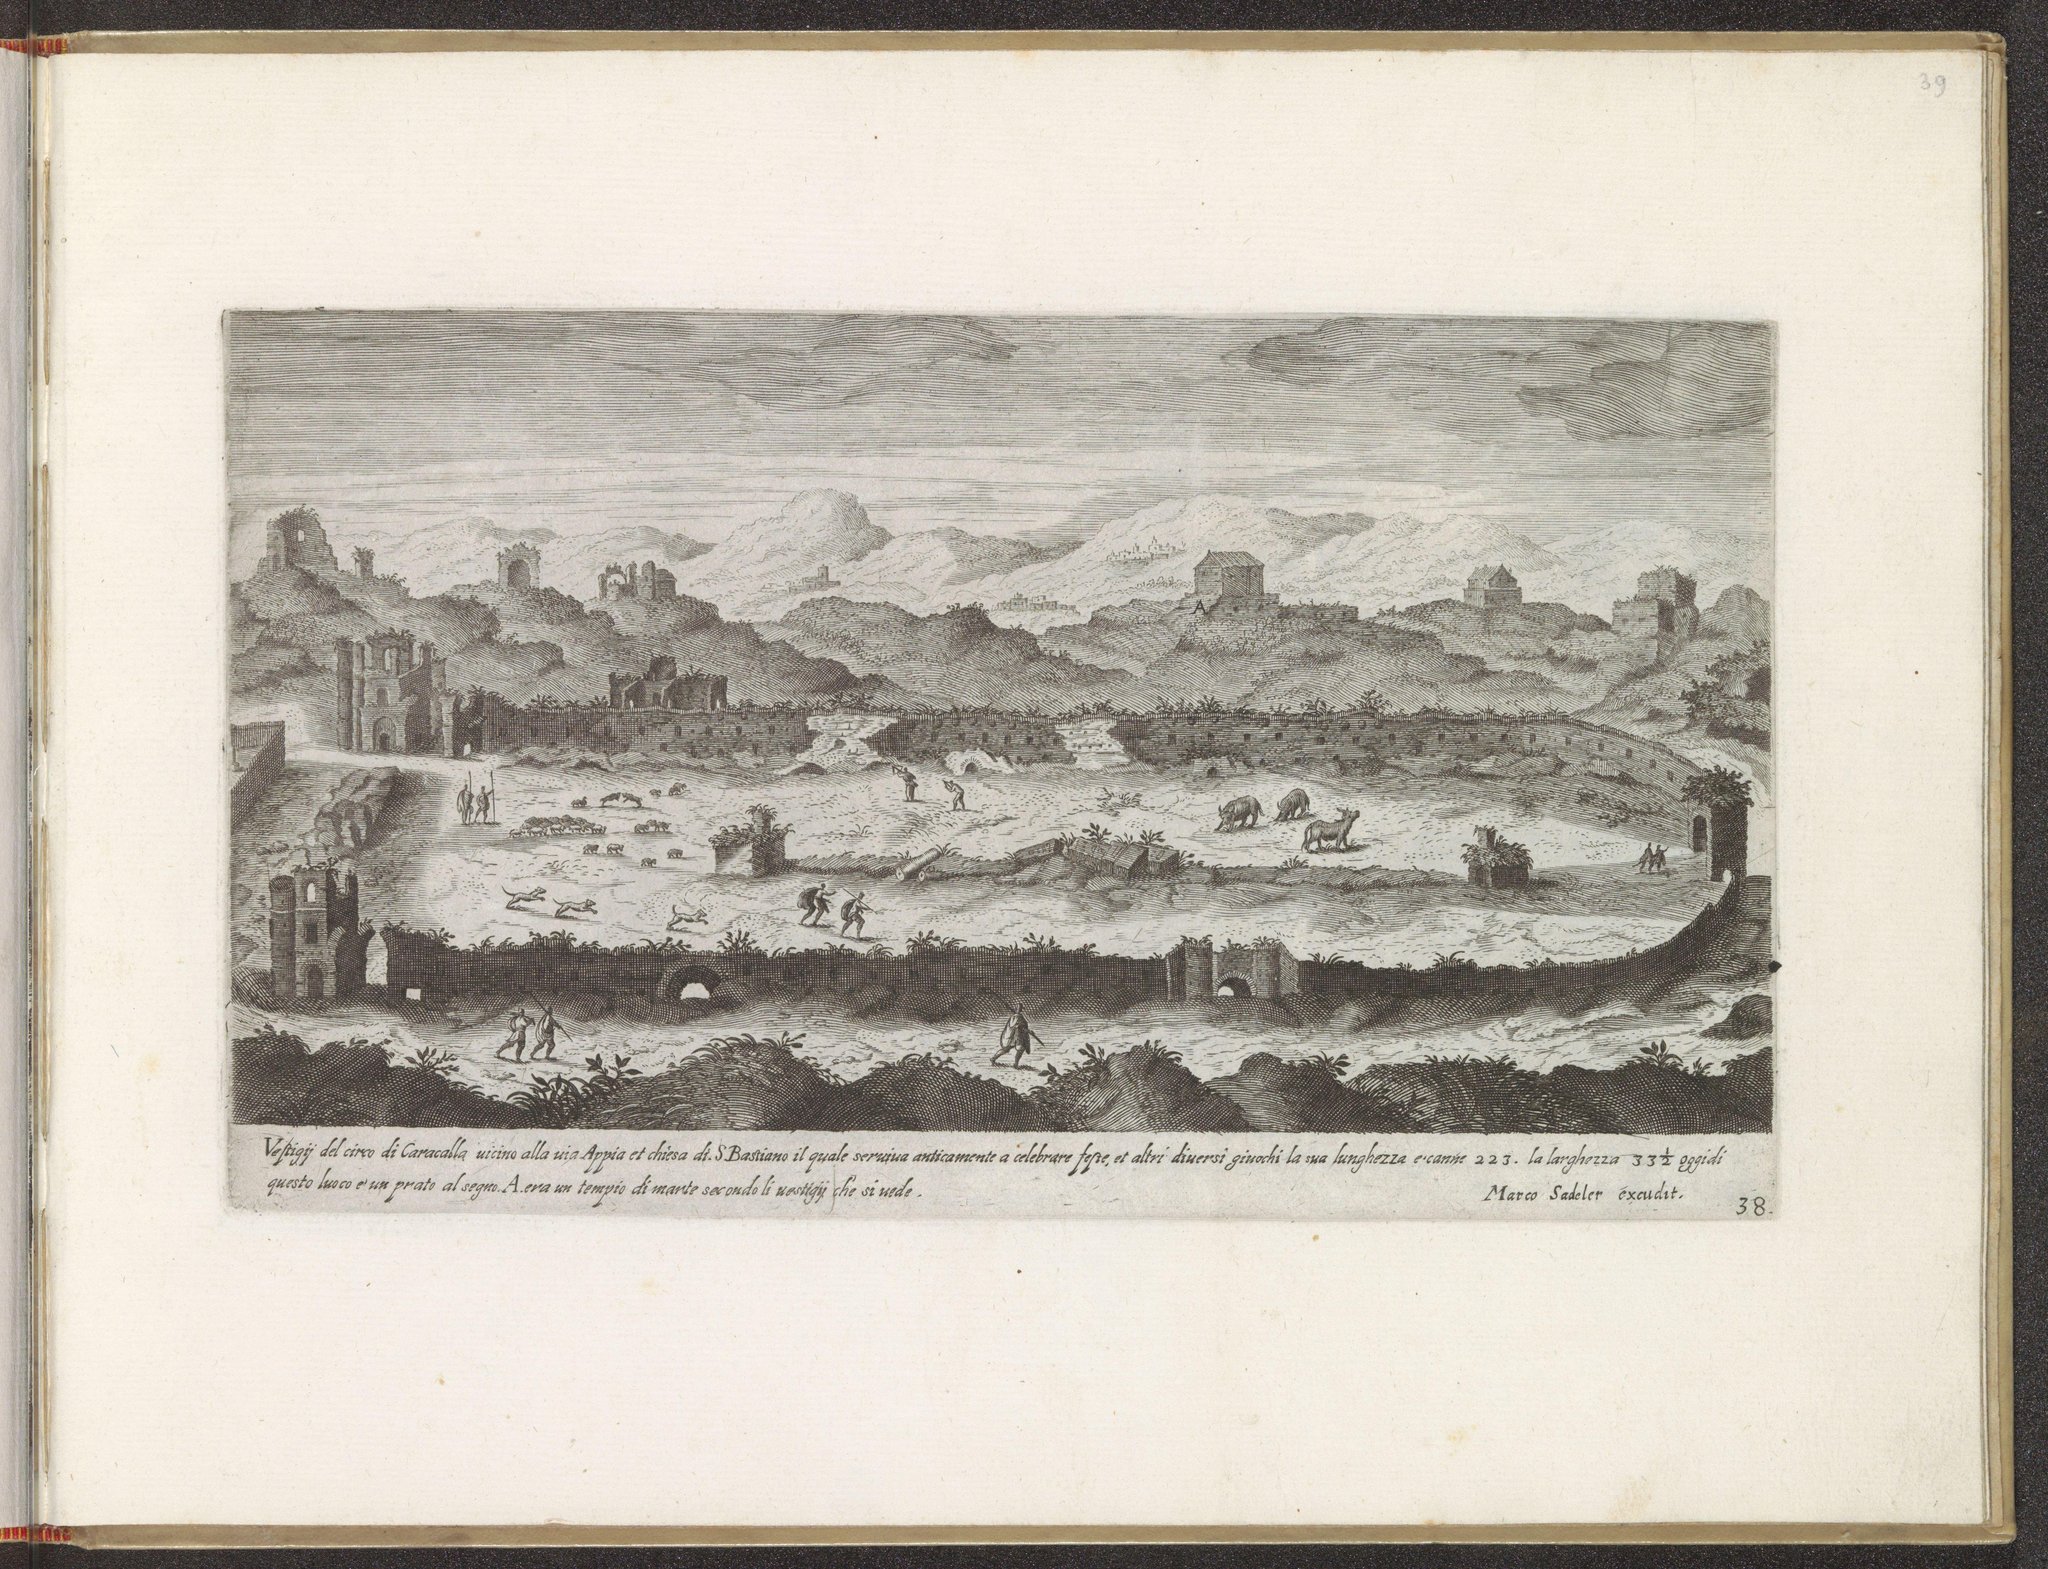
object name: print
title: Vestigi della antichita di Roma, Tivoli, Pozzuolo et altri Luochi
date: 1606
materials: paper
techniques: engraving, etching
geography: prague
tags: rome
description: Circus Maximus, gezien vanaf de Via Appia Antica. Figuren en dieren in de voorgrond. In de ondermarge twee regels tekst in het Italiaans. De prent maakt deel uit van een album.